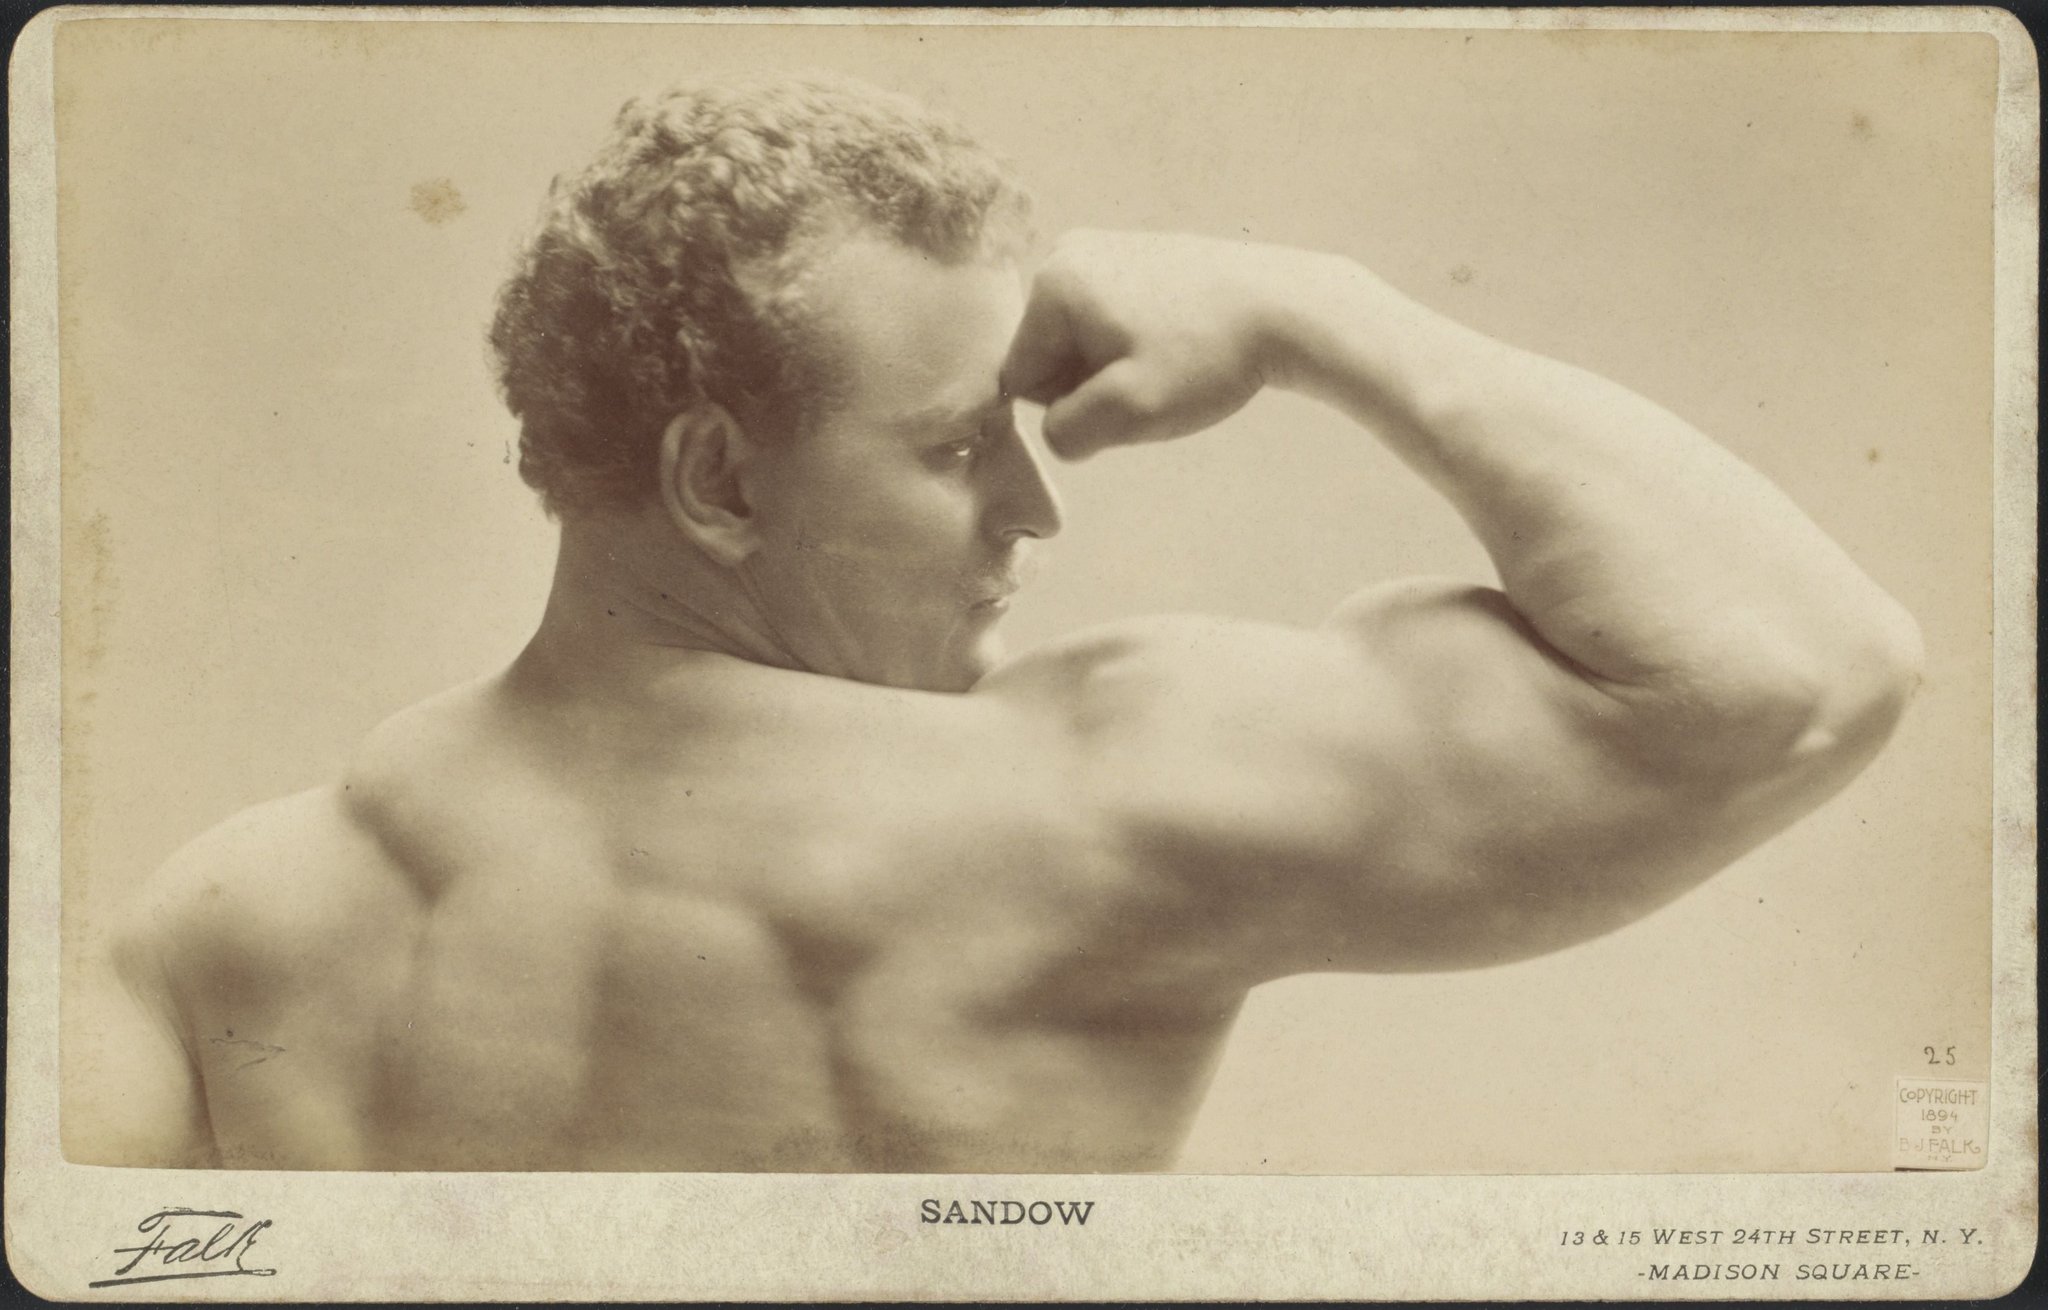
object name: photograph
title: Academische figuurstudie van Eugen Sandow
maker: benjamin joseph falk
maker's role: fotograaf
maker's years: 1853-1925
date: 1894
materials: cardboard, paper, photographic support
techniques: albumen print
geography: new york city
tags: historical persons, human figure of ideal proportions, e.g. academic nude, new york (city)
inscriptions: address: ‘13 & 15 west 24th street, N.Y. - Madison Square -’, negative number: ‘25’